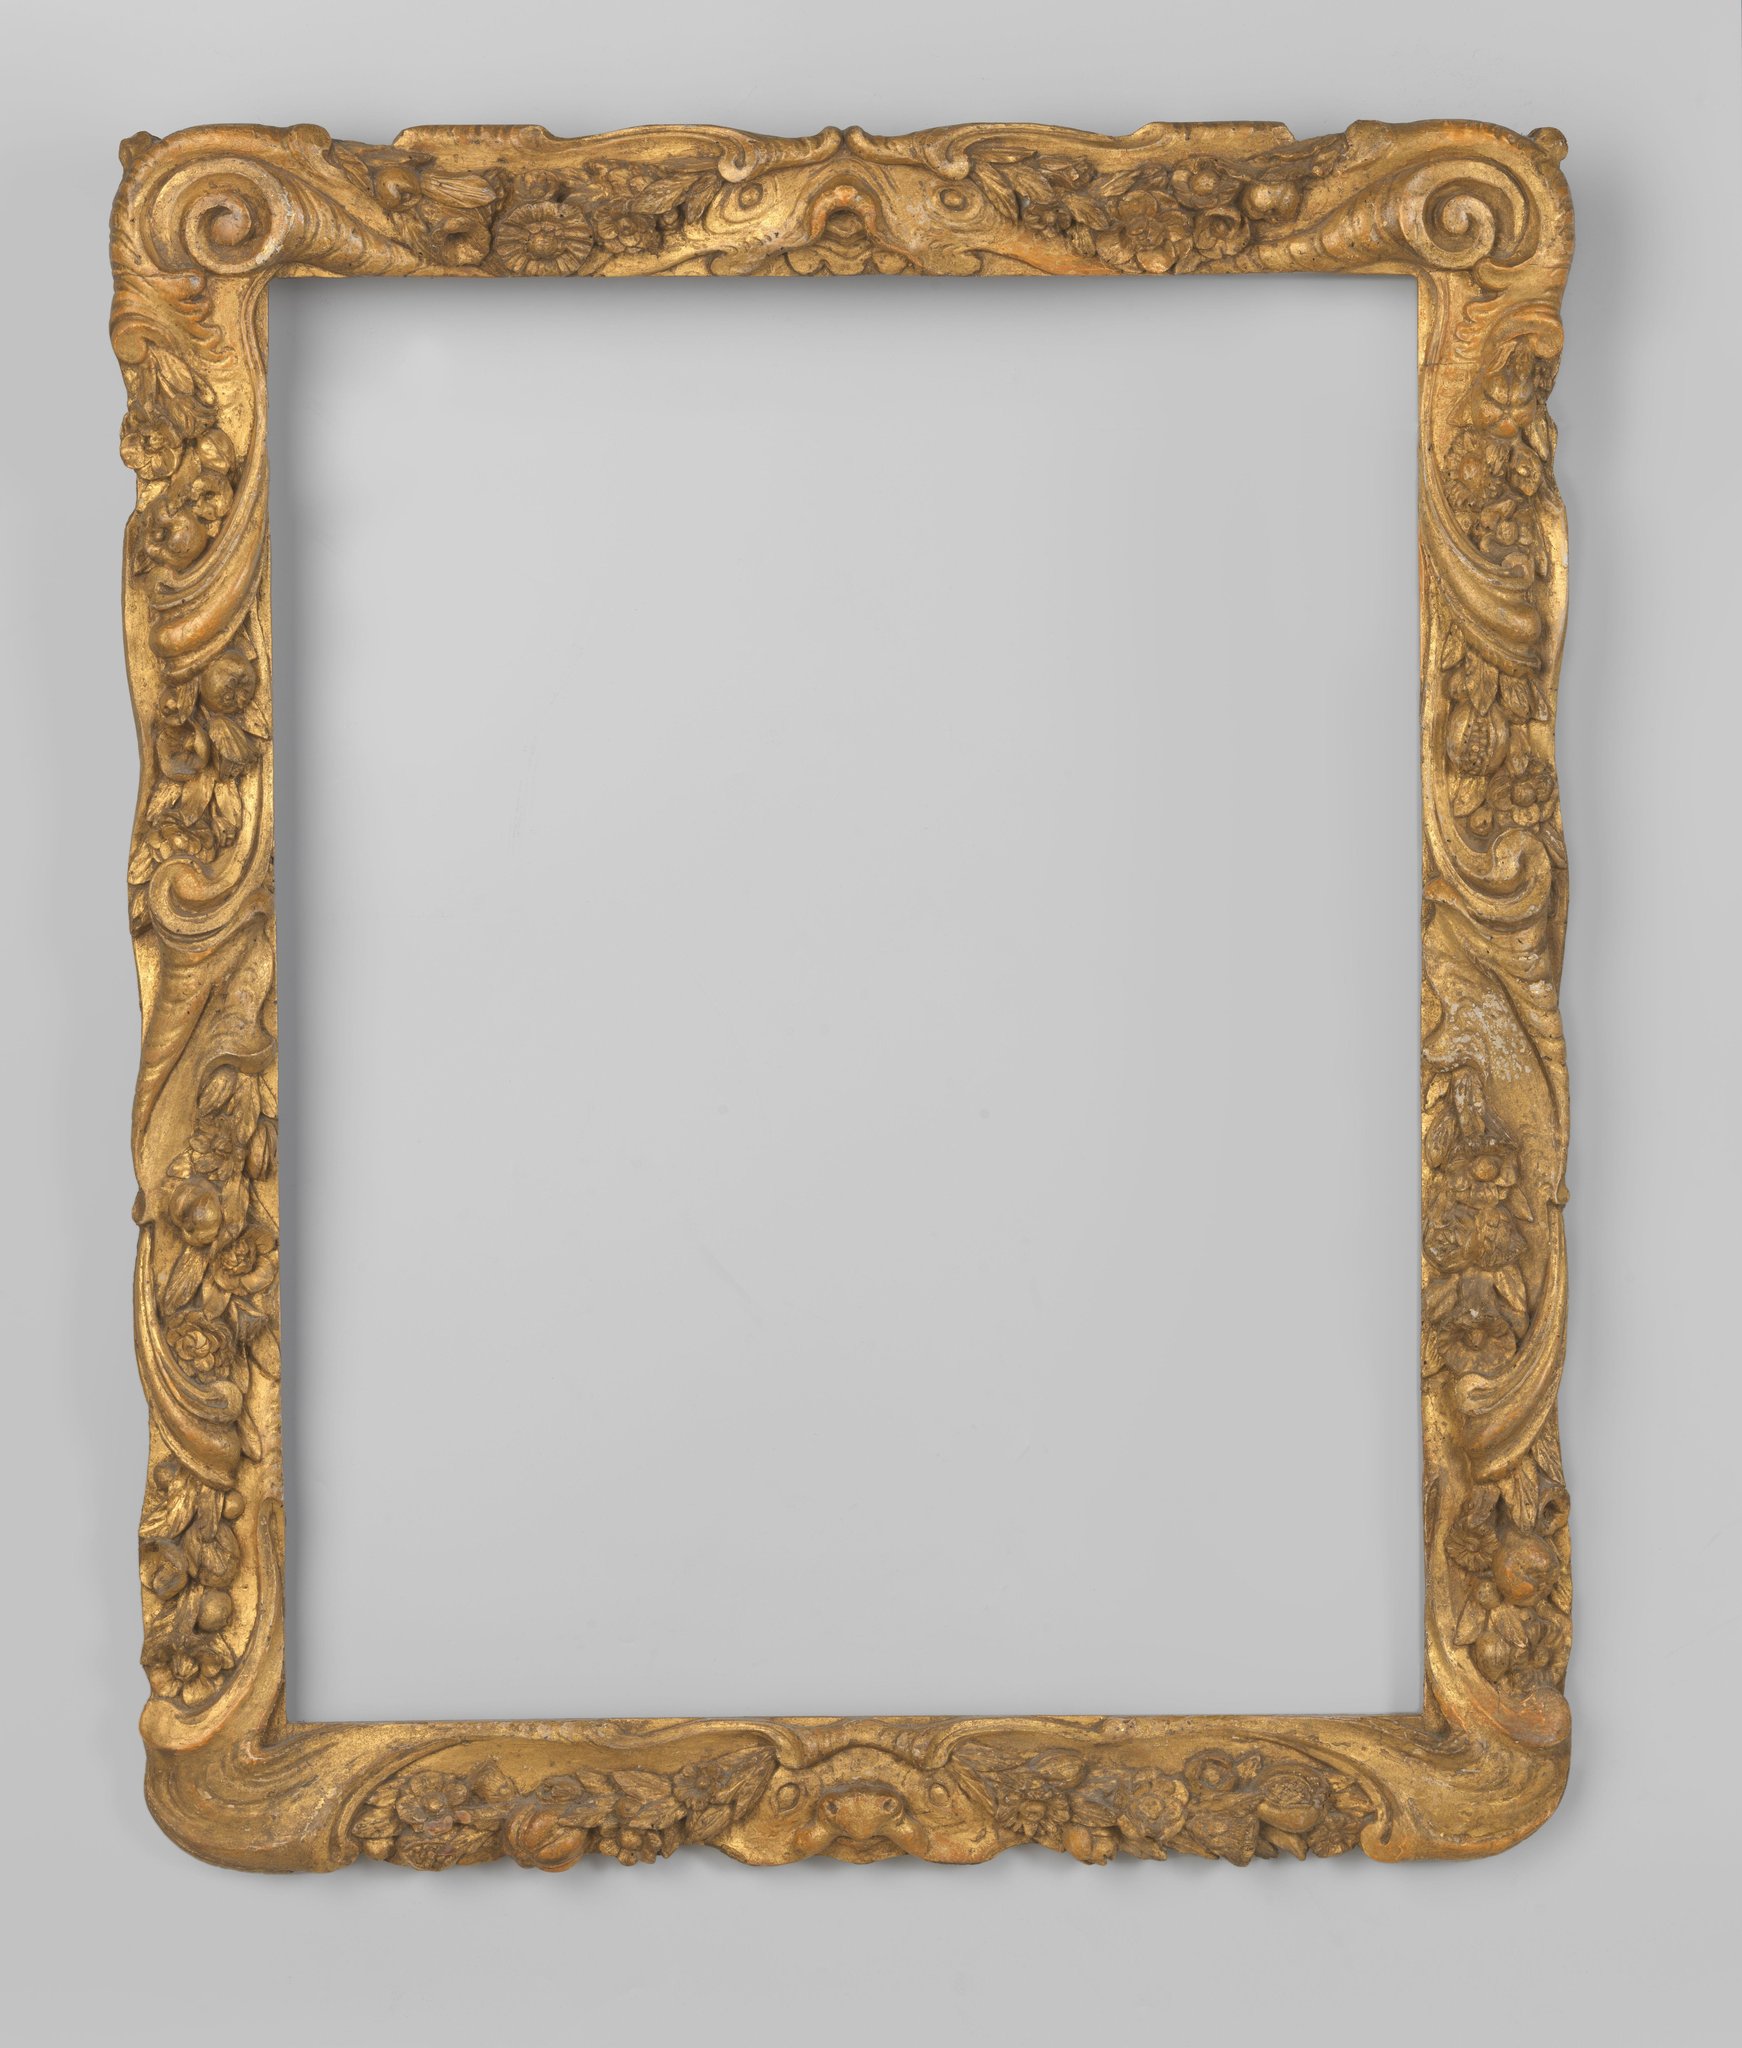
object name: frame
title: Vergulde lijst met kwabwerk en bloemenfestoen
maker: Anonymous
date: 1660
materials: gold leaf, wood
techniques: cutting, gilding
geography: northern netherlands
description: Vergulde lijst met kwabwerk en een festoen met bloemen en bladeren. Horens en spiraalvormige sieren de bovenhoeken en de boven- en onderregel zijn in het midden bezet met een monsterkop. Het kwabwerk is symmetrisch over de lijst verdeeld en wordt rondom onderbroken door een festoen met bloemen en bladeren. Aan de achterzijde is de lijst geschaafd en de zool vervangen.